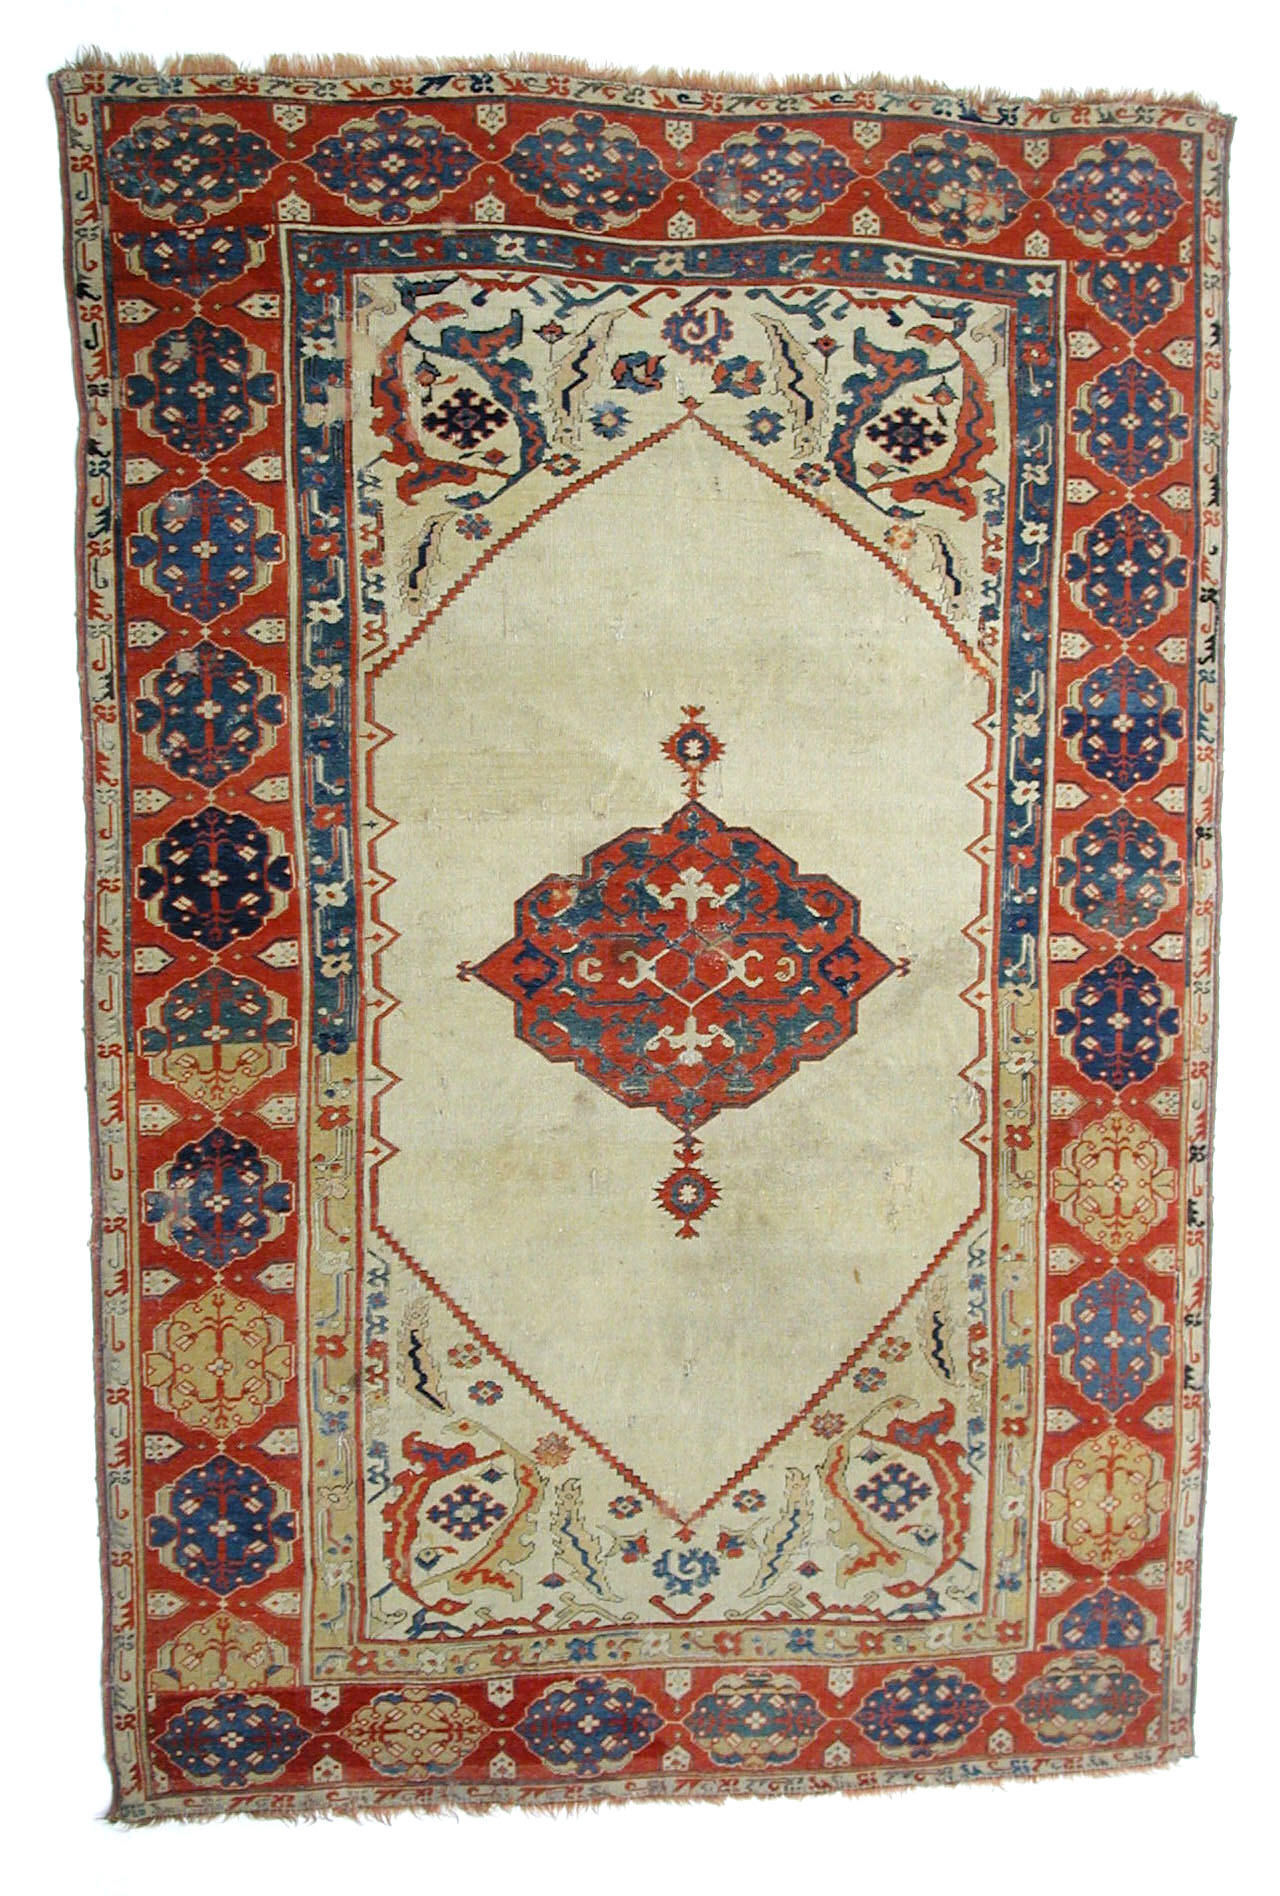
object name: carpet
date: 1701-1800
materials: wool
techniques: pile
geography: turkey